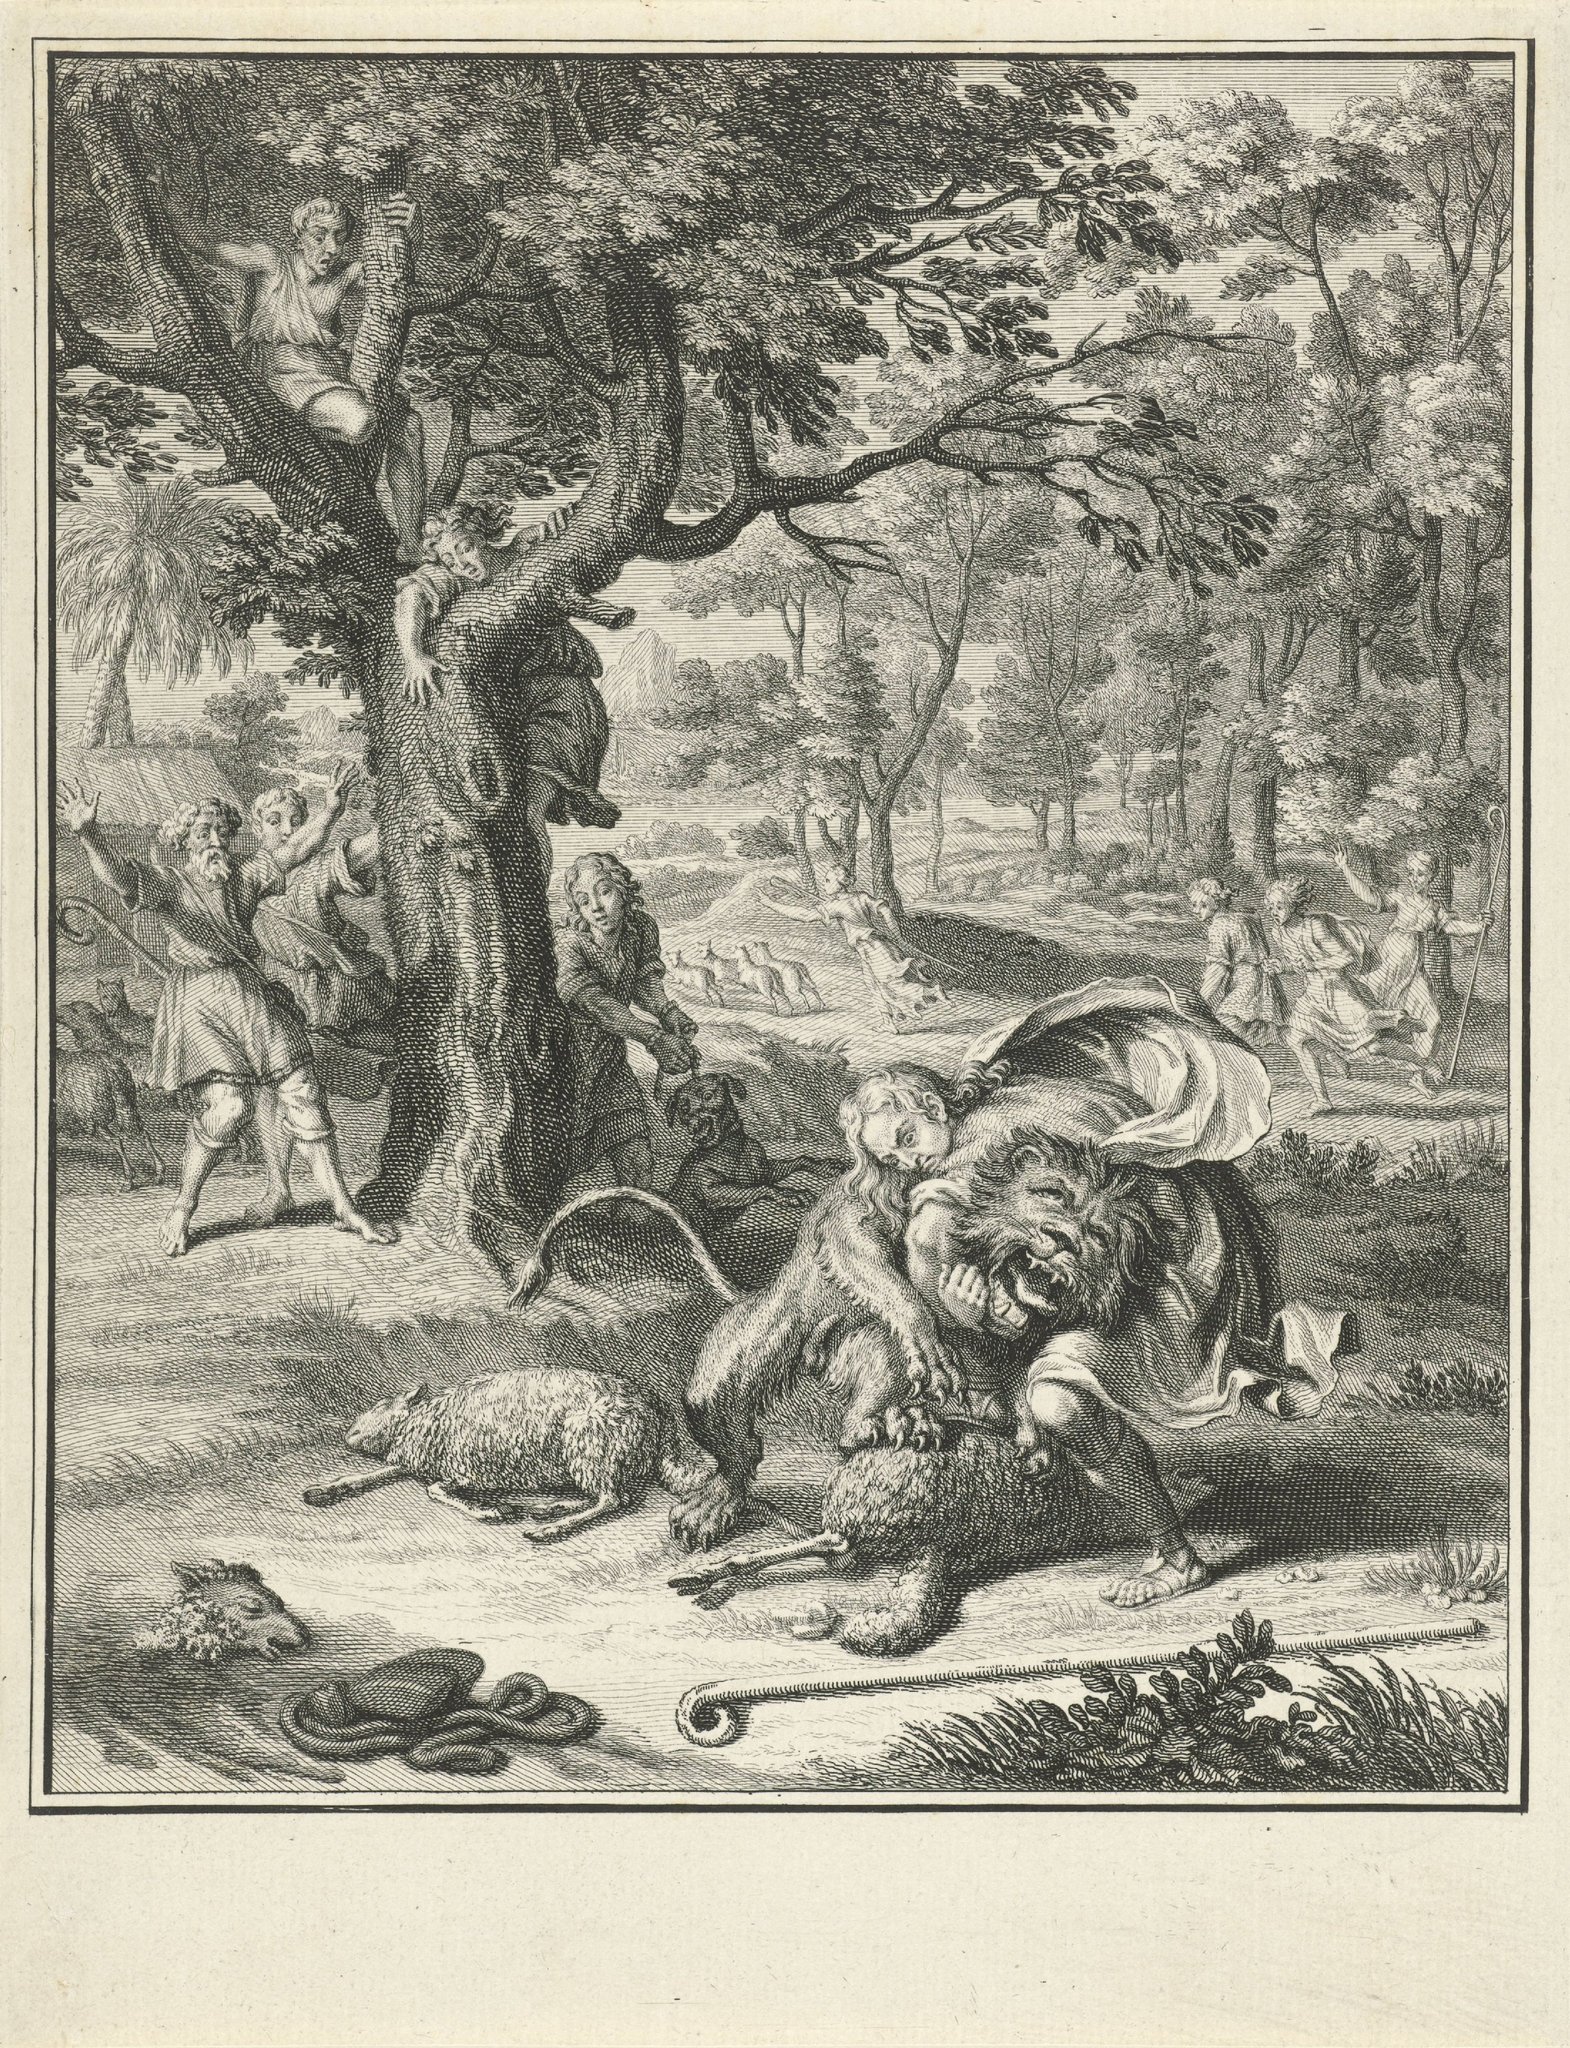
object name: print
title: Telemachus doodt een leeuw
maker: bernard picart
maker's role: draughtsman, print maker, publisher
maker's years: 1673-1733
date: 1732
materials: paper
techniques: engraving, etching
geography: amsterdam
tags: (story of) telemachus - aggressive, unfriendly activities and relationships, beasts of prey, predatory animals: lion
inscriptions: collector's mark: Lugt 240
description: Tweede staat van deze prent ook gebruikt als illustratie in: Fénelon, François de Salignac La Mothe. Les avantures de Telemaque, fils d'Ulysse. Amsterdam/ Rotterdam, J. Wetstein, G. Smith, Z. Chatelain, J. Hofhout, 1734.